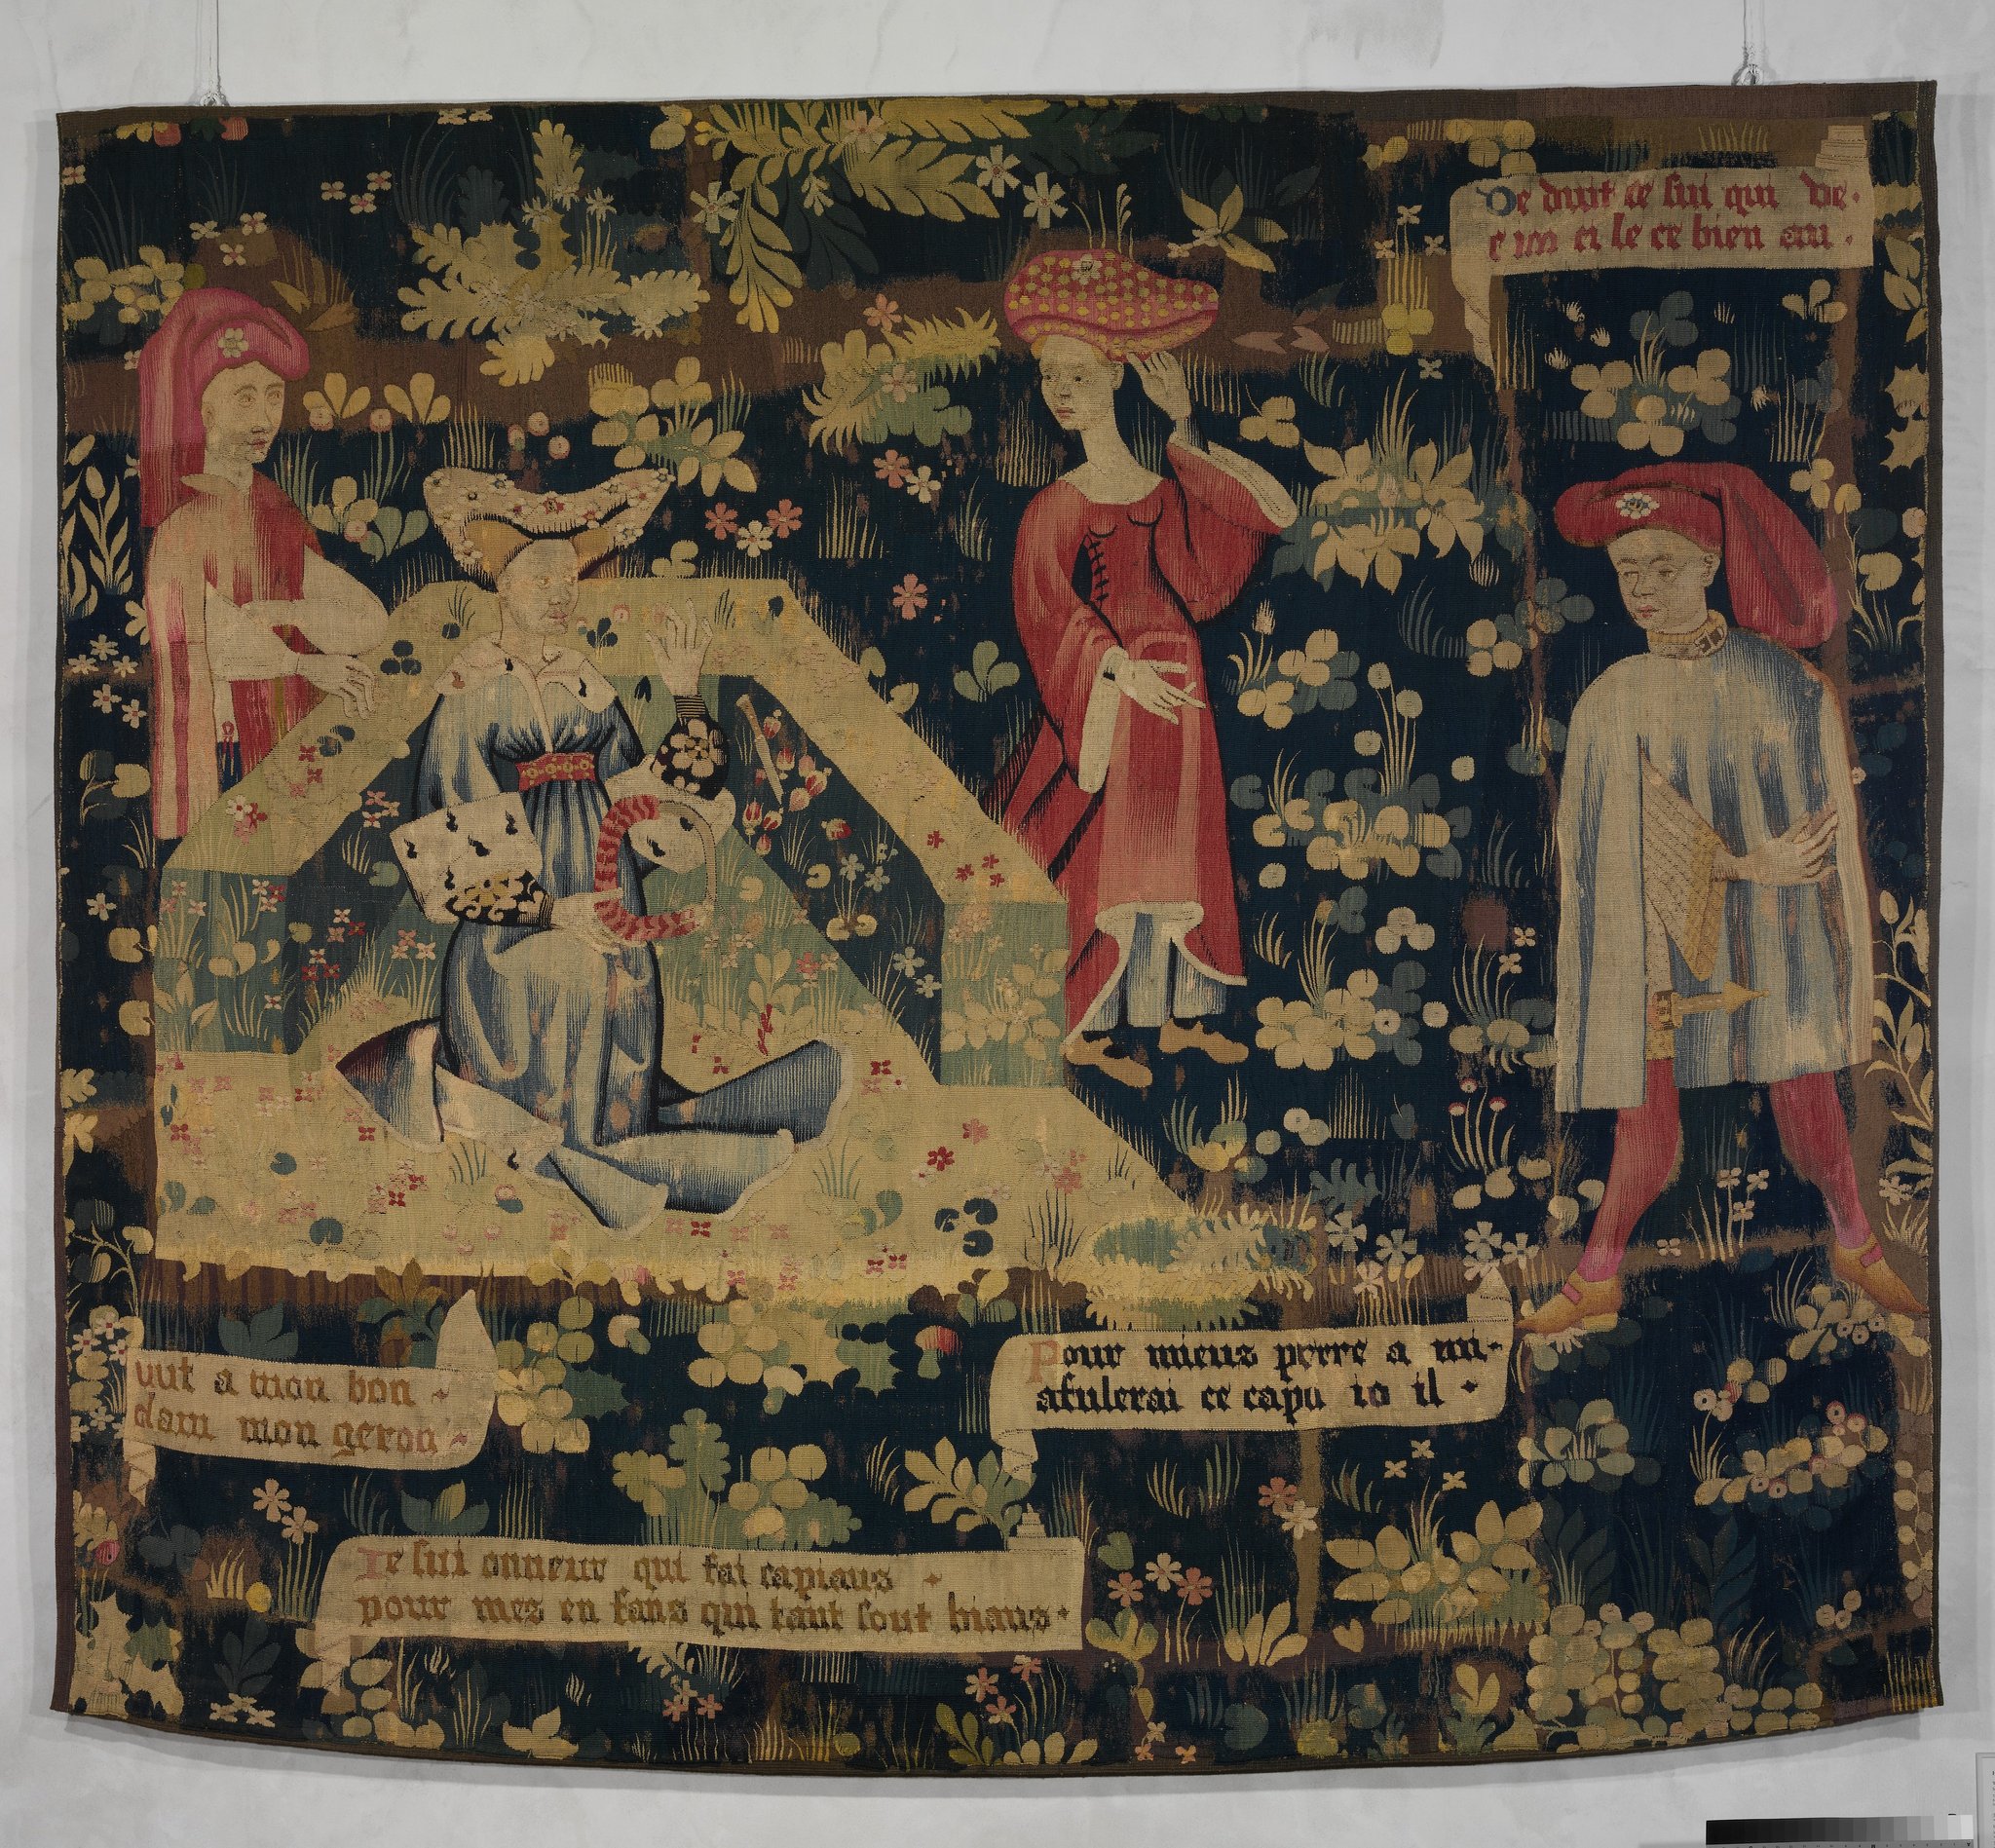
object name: tapestry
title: Honor Making a Chaplet of Roses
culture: south netherlandish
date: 1410-1420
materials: wool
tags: gardens,men,women,roses